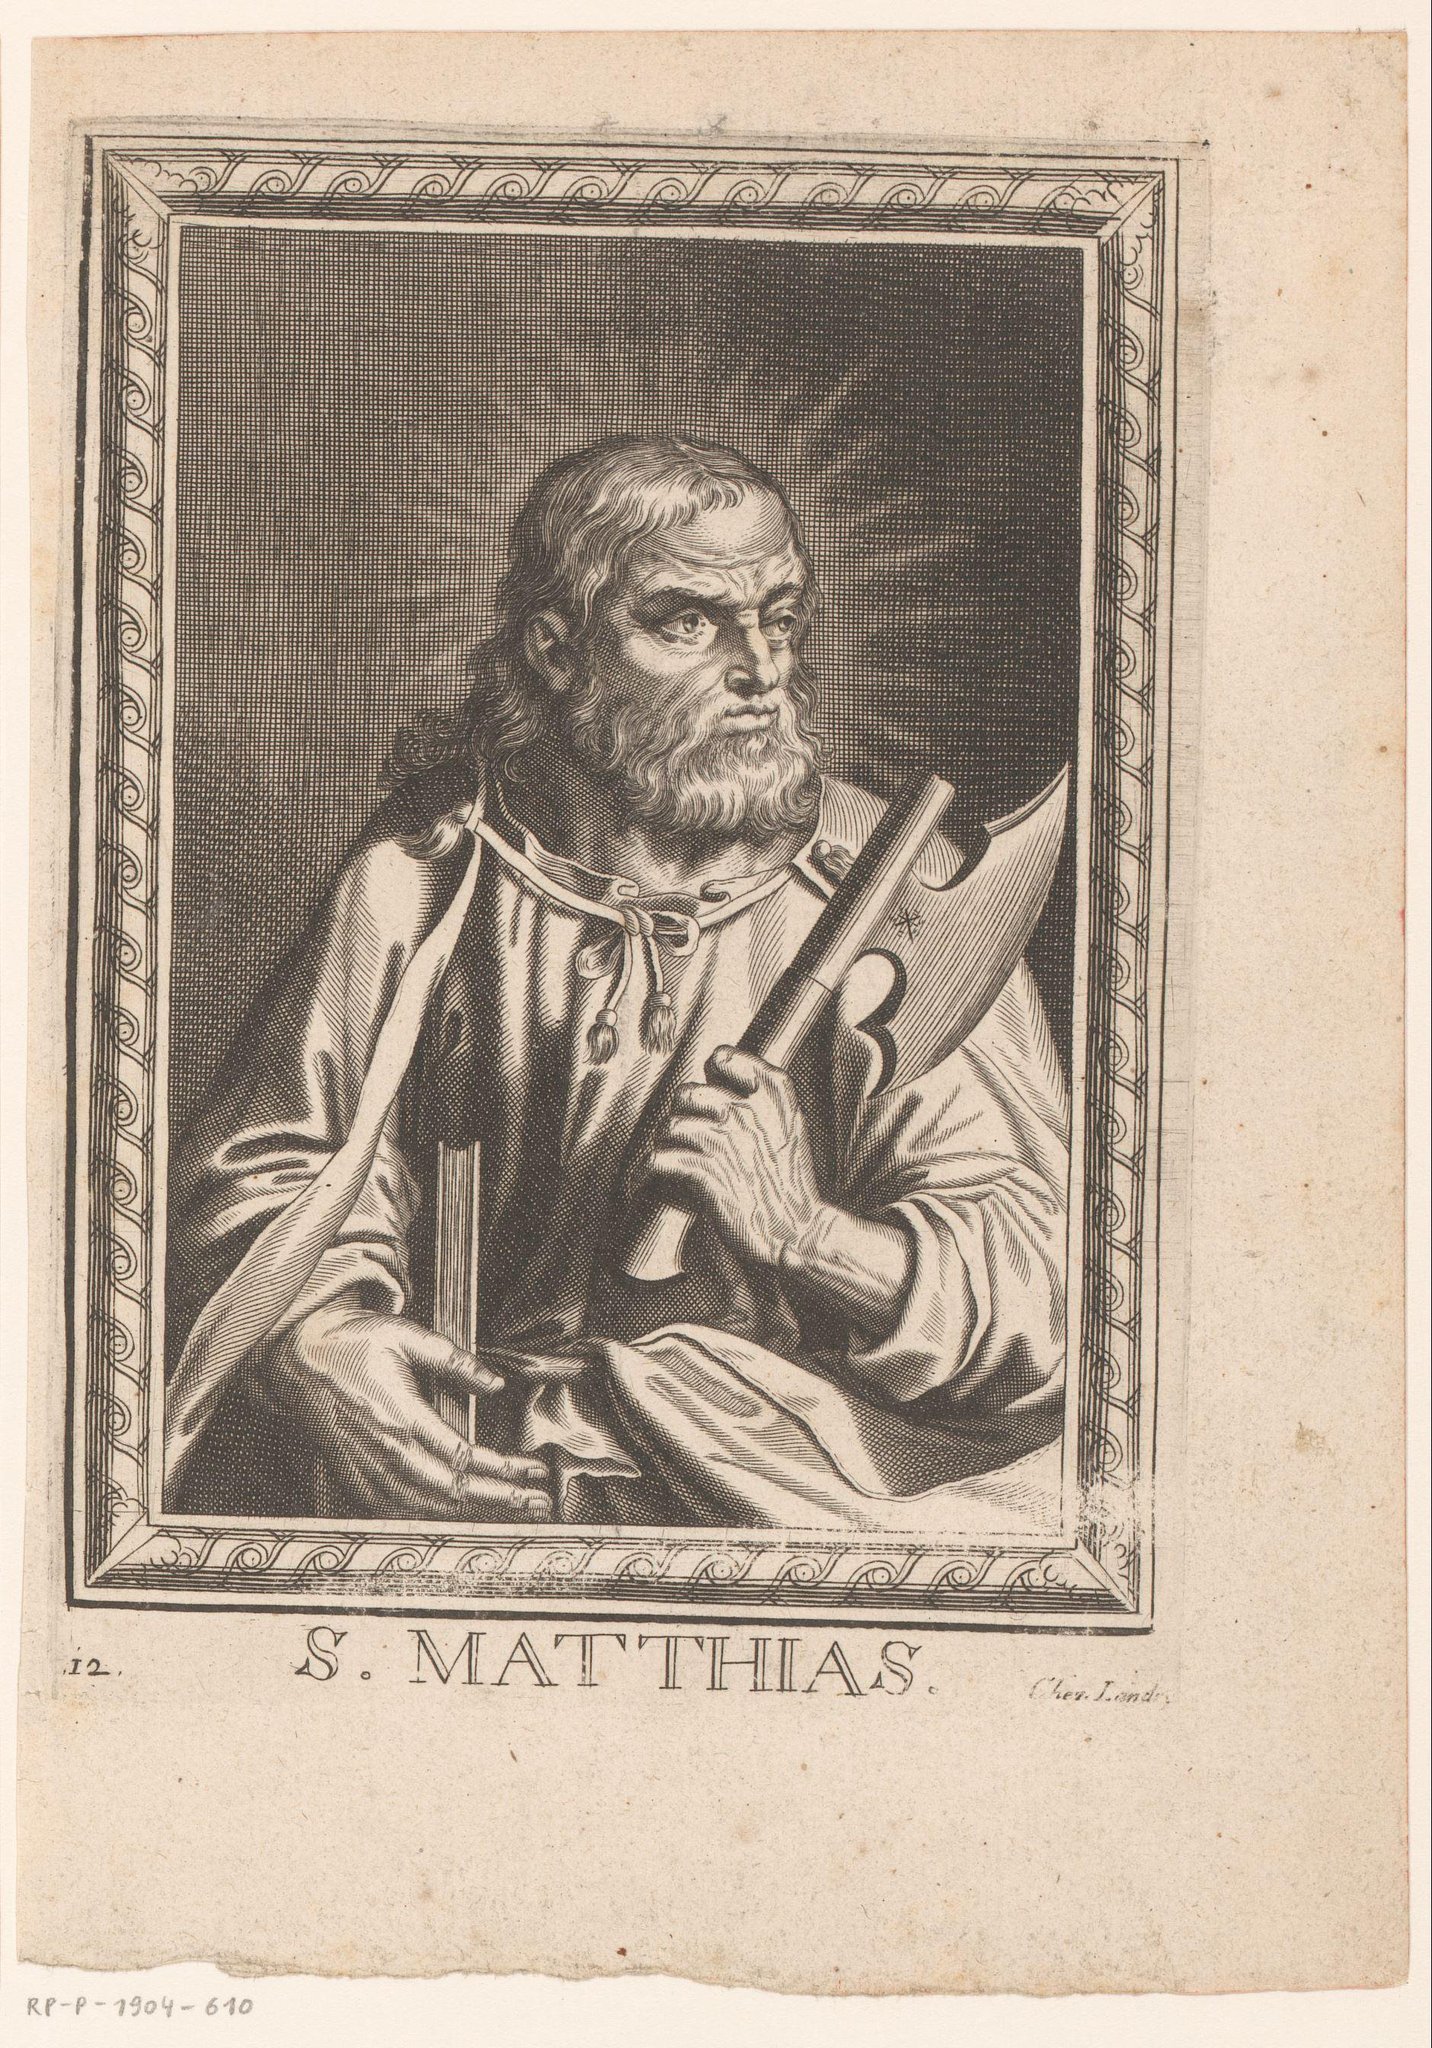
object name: print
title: Twaalf apostelen, de vier kerkvaders en Maria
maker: pierre landry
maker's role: print maker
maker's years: 1630-1701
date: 1640-1701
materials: paper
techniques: engraving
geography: paris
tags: the apostle and martyr matthias; possible attributes: axe, book, cross, halberd, scroll, sword - portrait of male saint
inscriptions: collector's mark: Lugt 2228